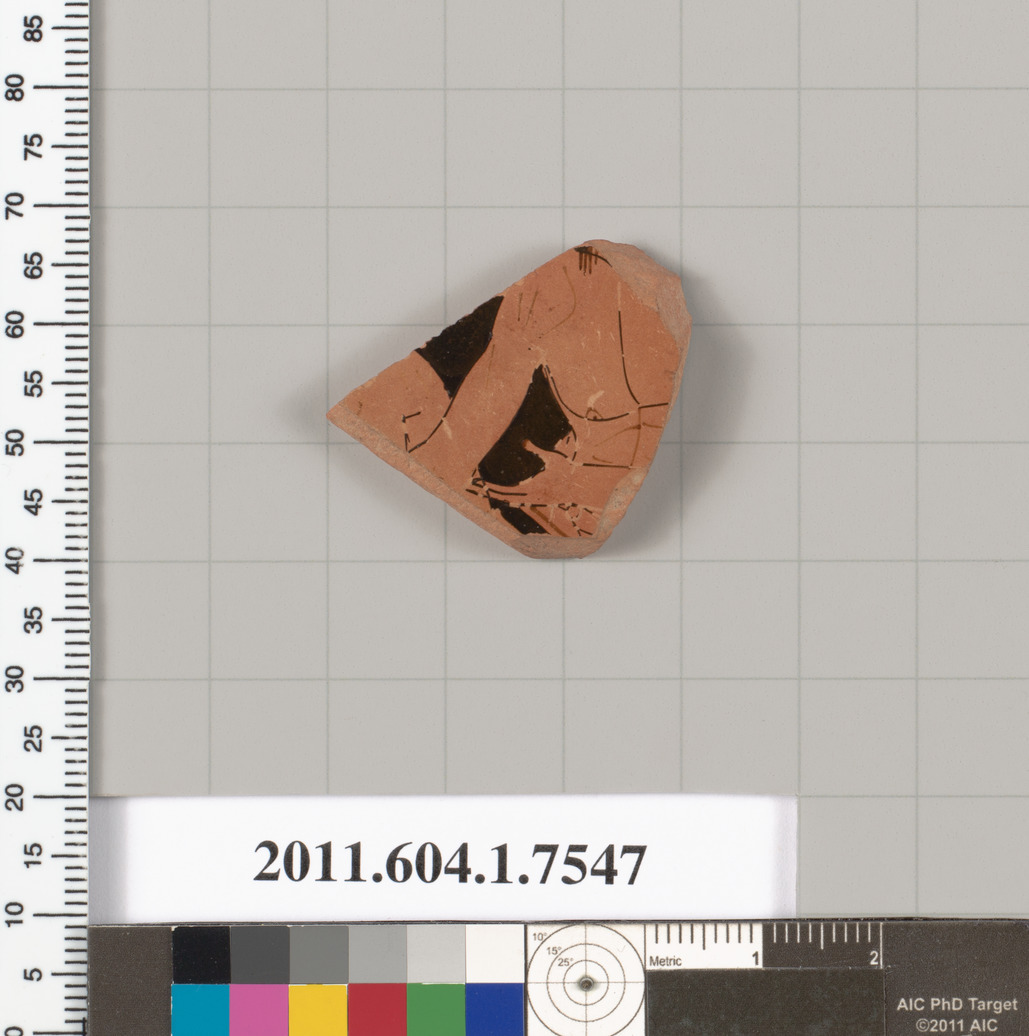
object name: kylix fragment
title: Terracotta fragment of a kylix (drinking cup)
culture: greek, attic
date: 460-450 BCE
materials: terracotta